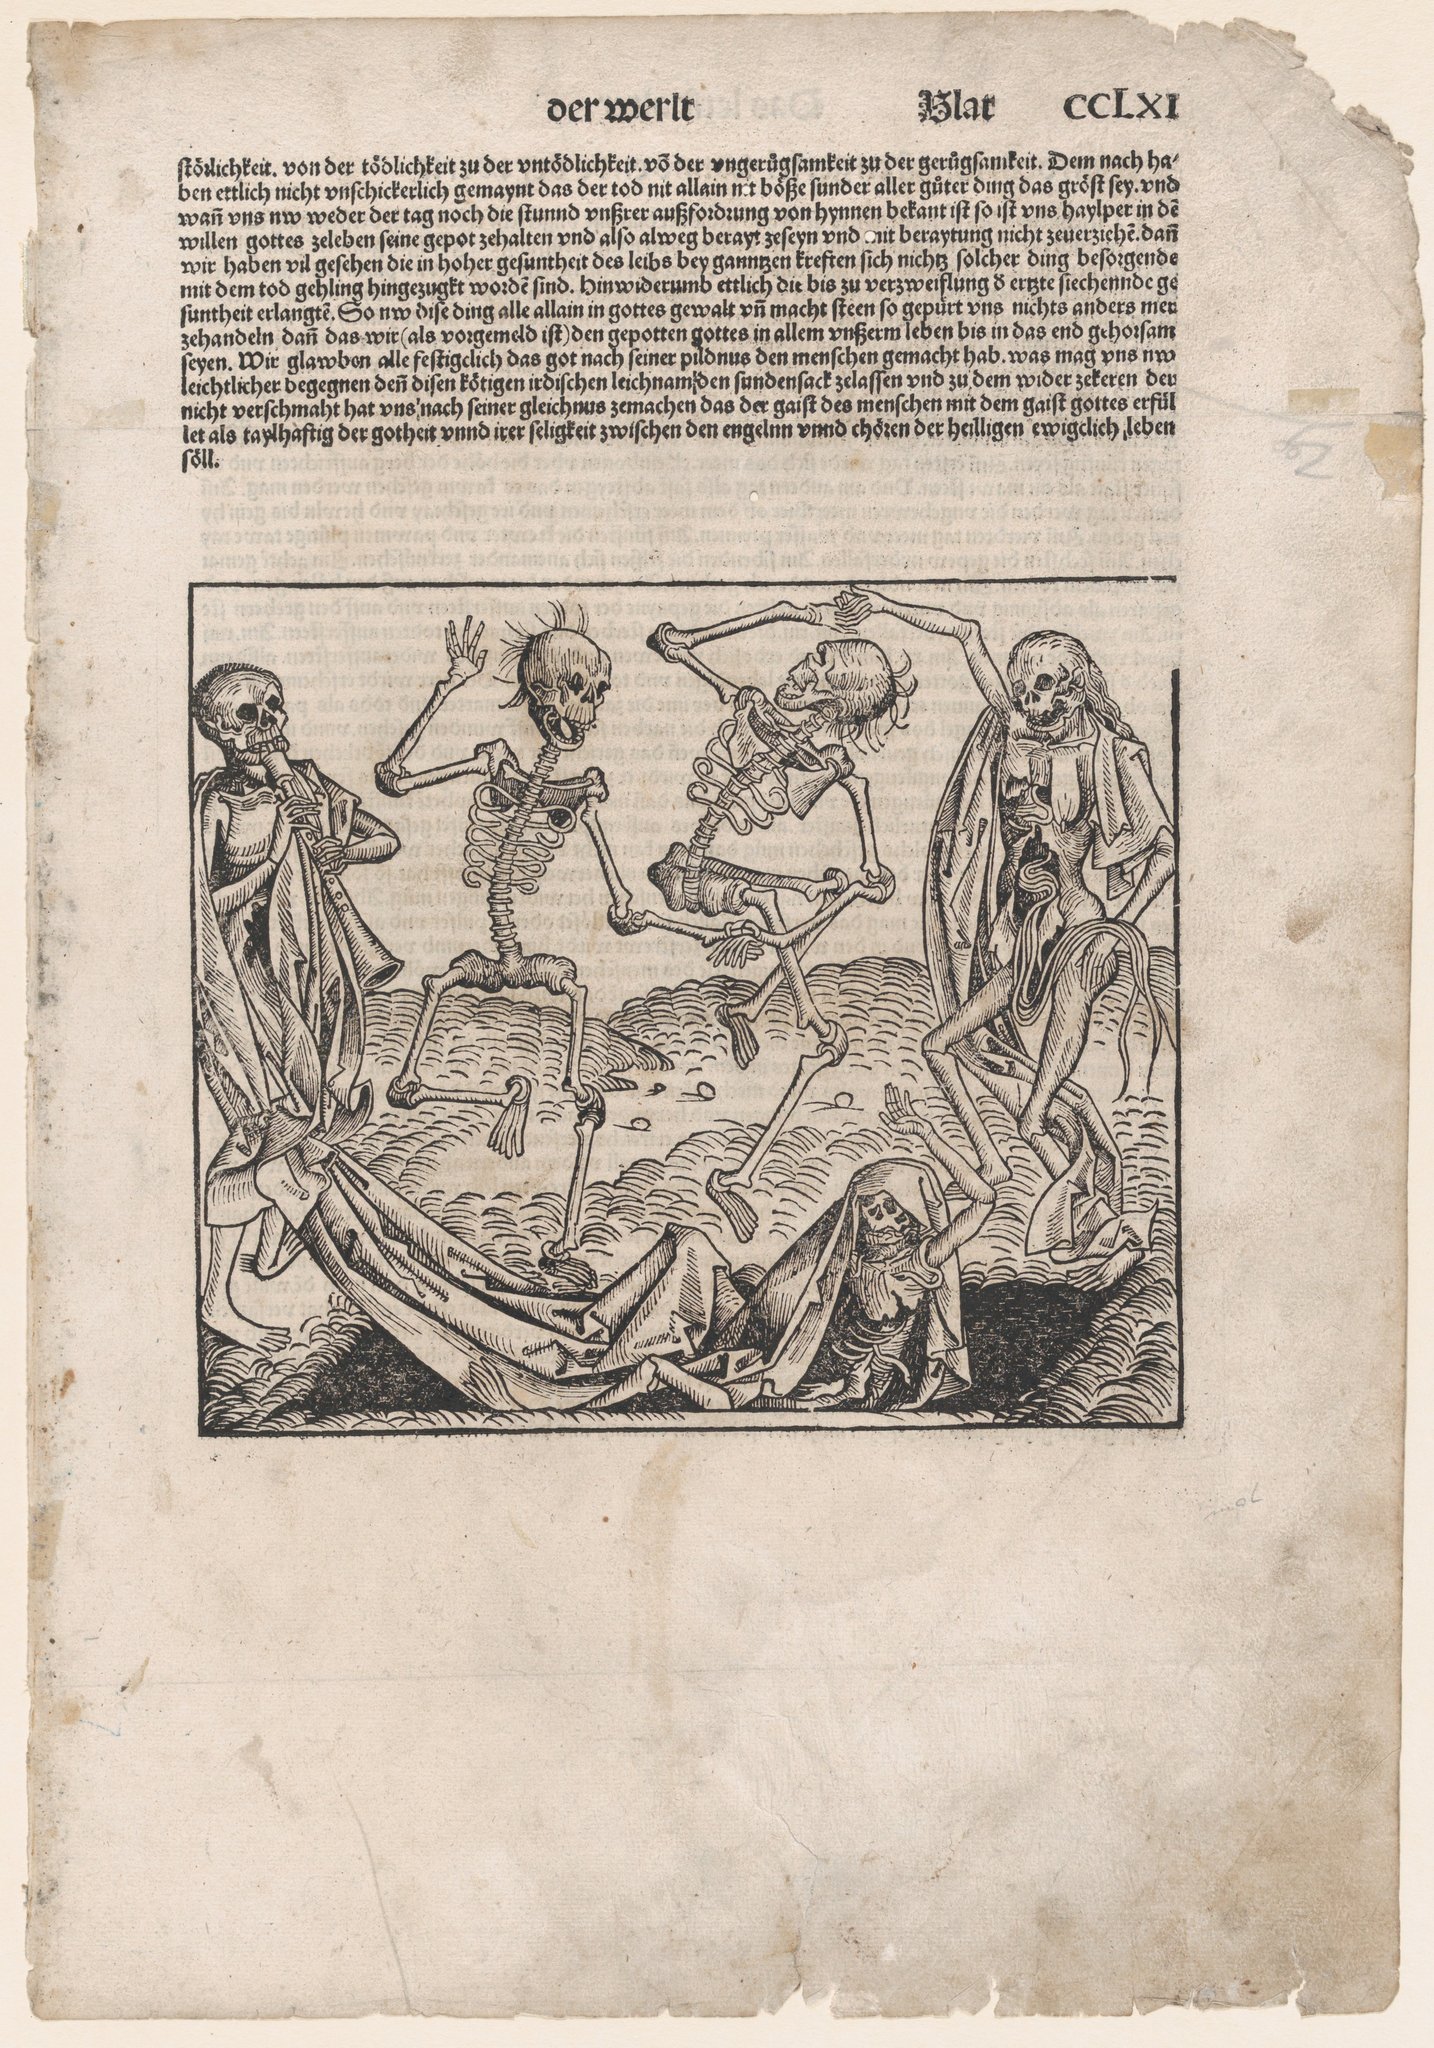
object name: print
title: Dance of Death, leaf from "The Nuremberg Chronicle"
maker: michael wolgemut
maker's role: artist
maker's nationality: german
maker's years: 1434-1519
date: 1493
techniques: letterpress, woodcut